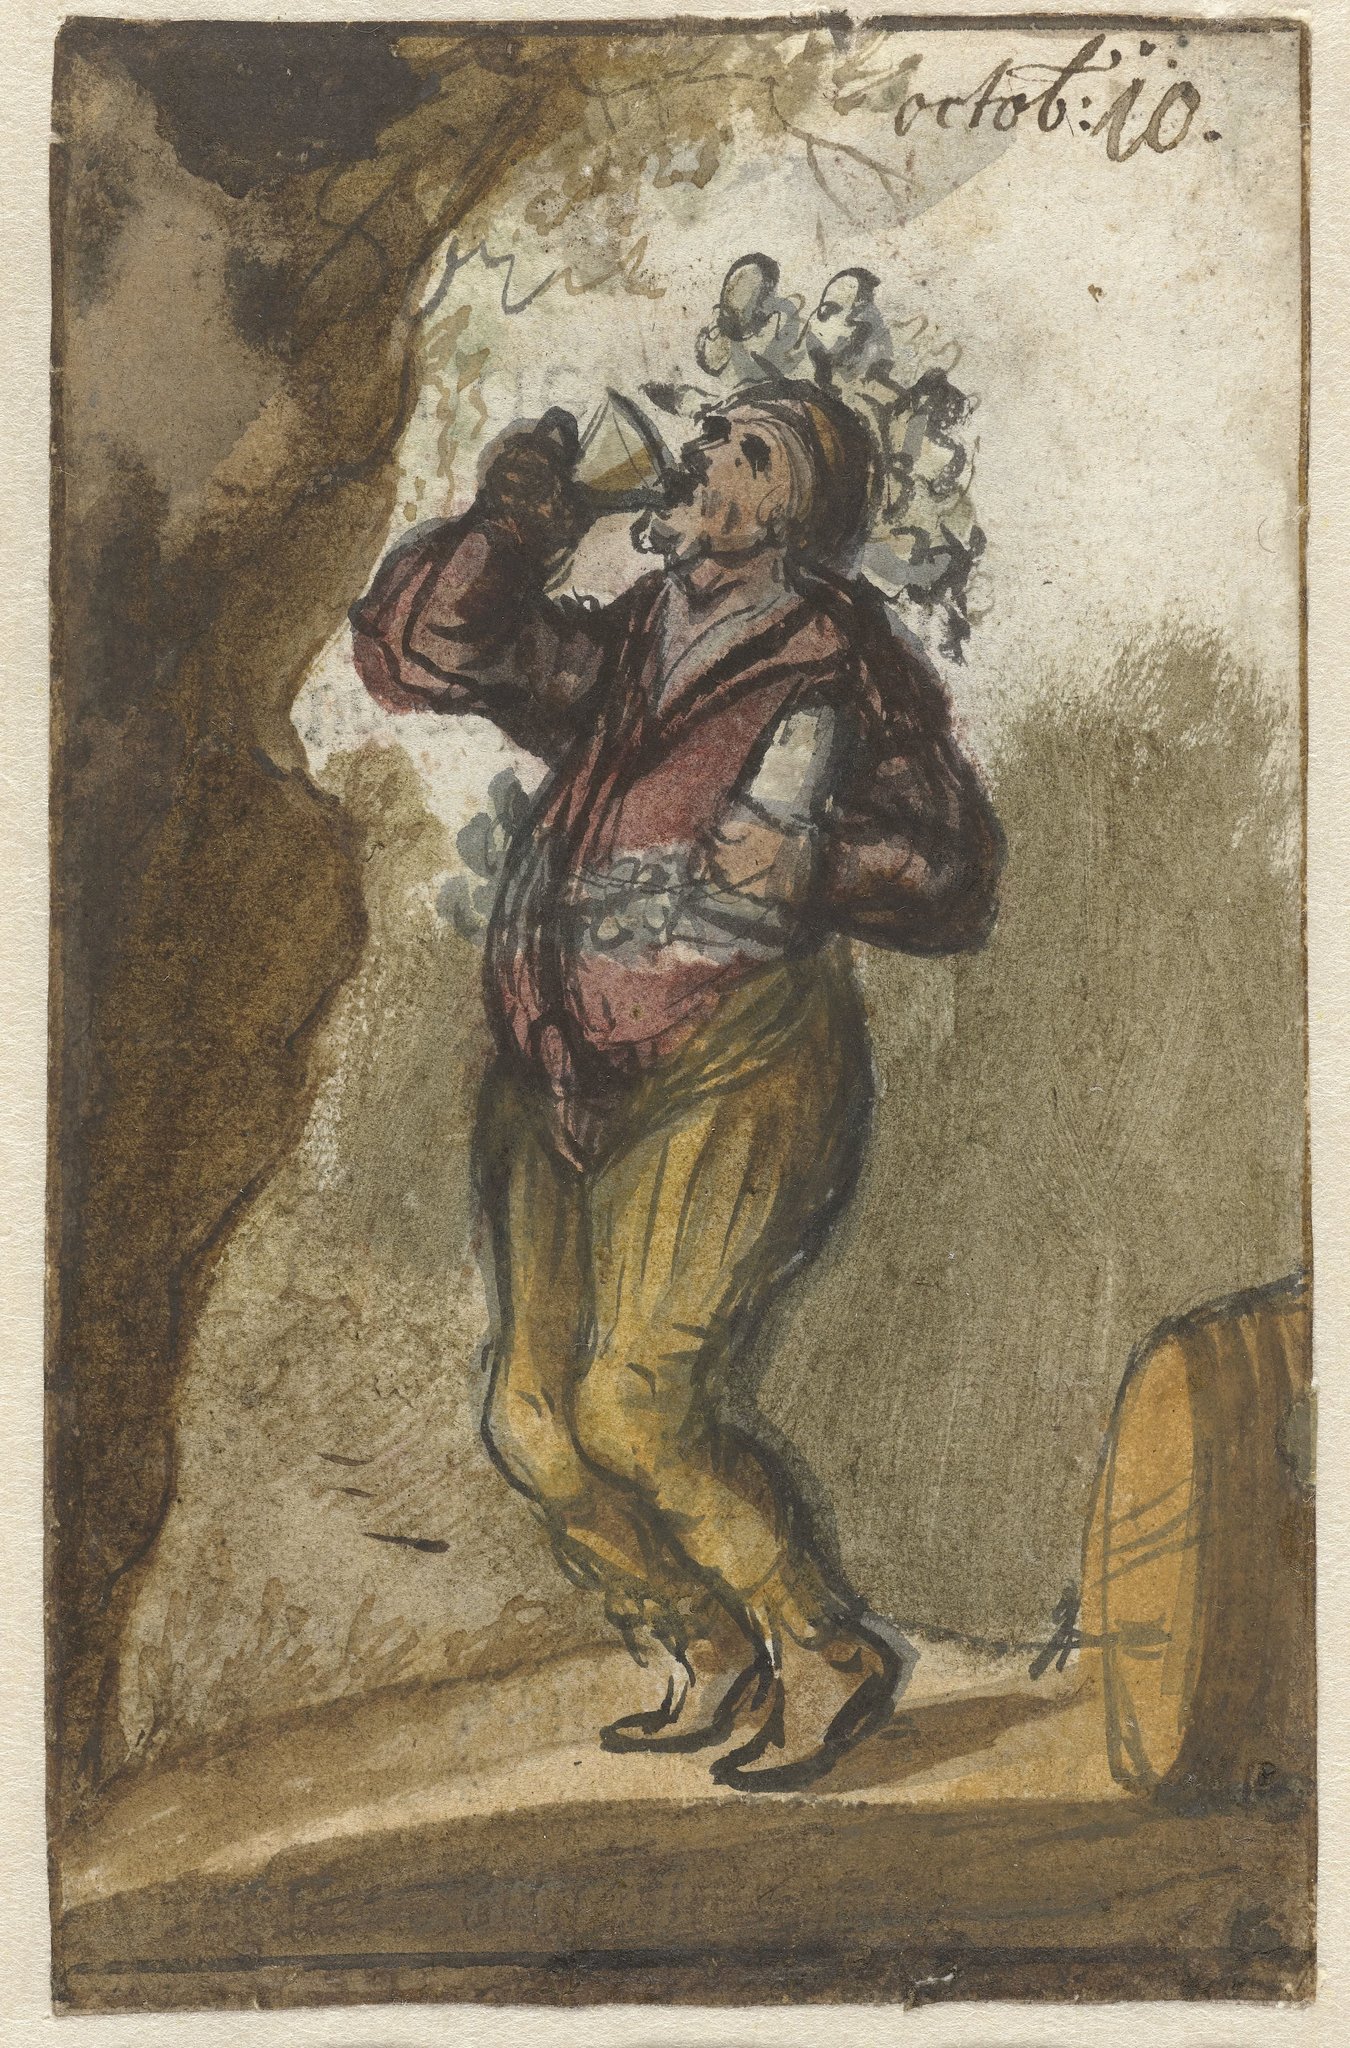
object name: drawing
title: De twaalf maanden van het jaar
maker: Anonymous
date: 1600-1699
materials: paper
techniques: brush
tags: october and its 'labours'